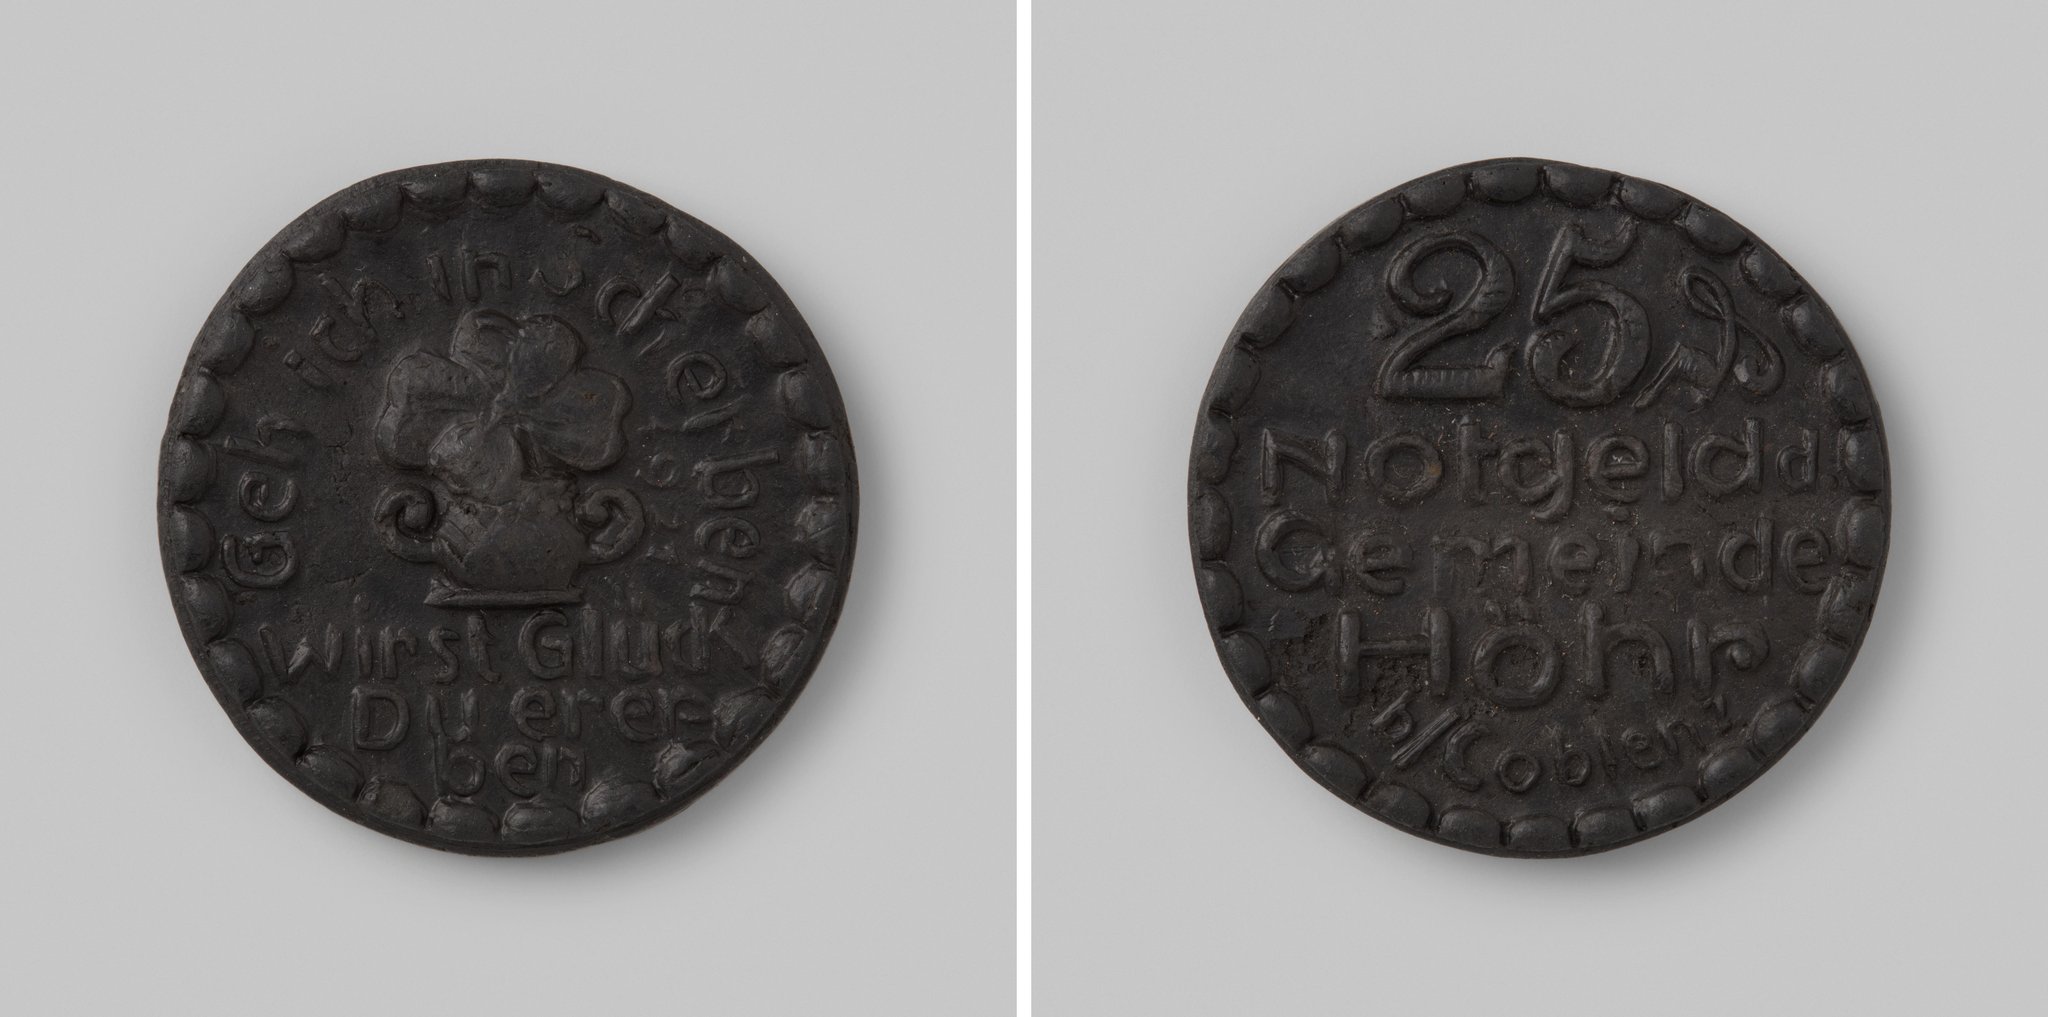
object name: coin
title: 25 mark notgeld uit Duitsland, Höhr, Coblenz,1921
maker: a. kamp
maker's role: sculptor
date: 1921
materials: porcelain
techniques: casting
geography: höhr-grenzhausen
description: Porseleinen zwart gekleurde pseudomunt. Voorzijde: vaas met bloemen. Keerzijde: waarde-aanduiding in twee regels, waaronder plaats-aanduiding in drie regels. Gladde rand.